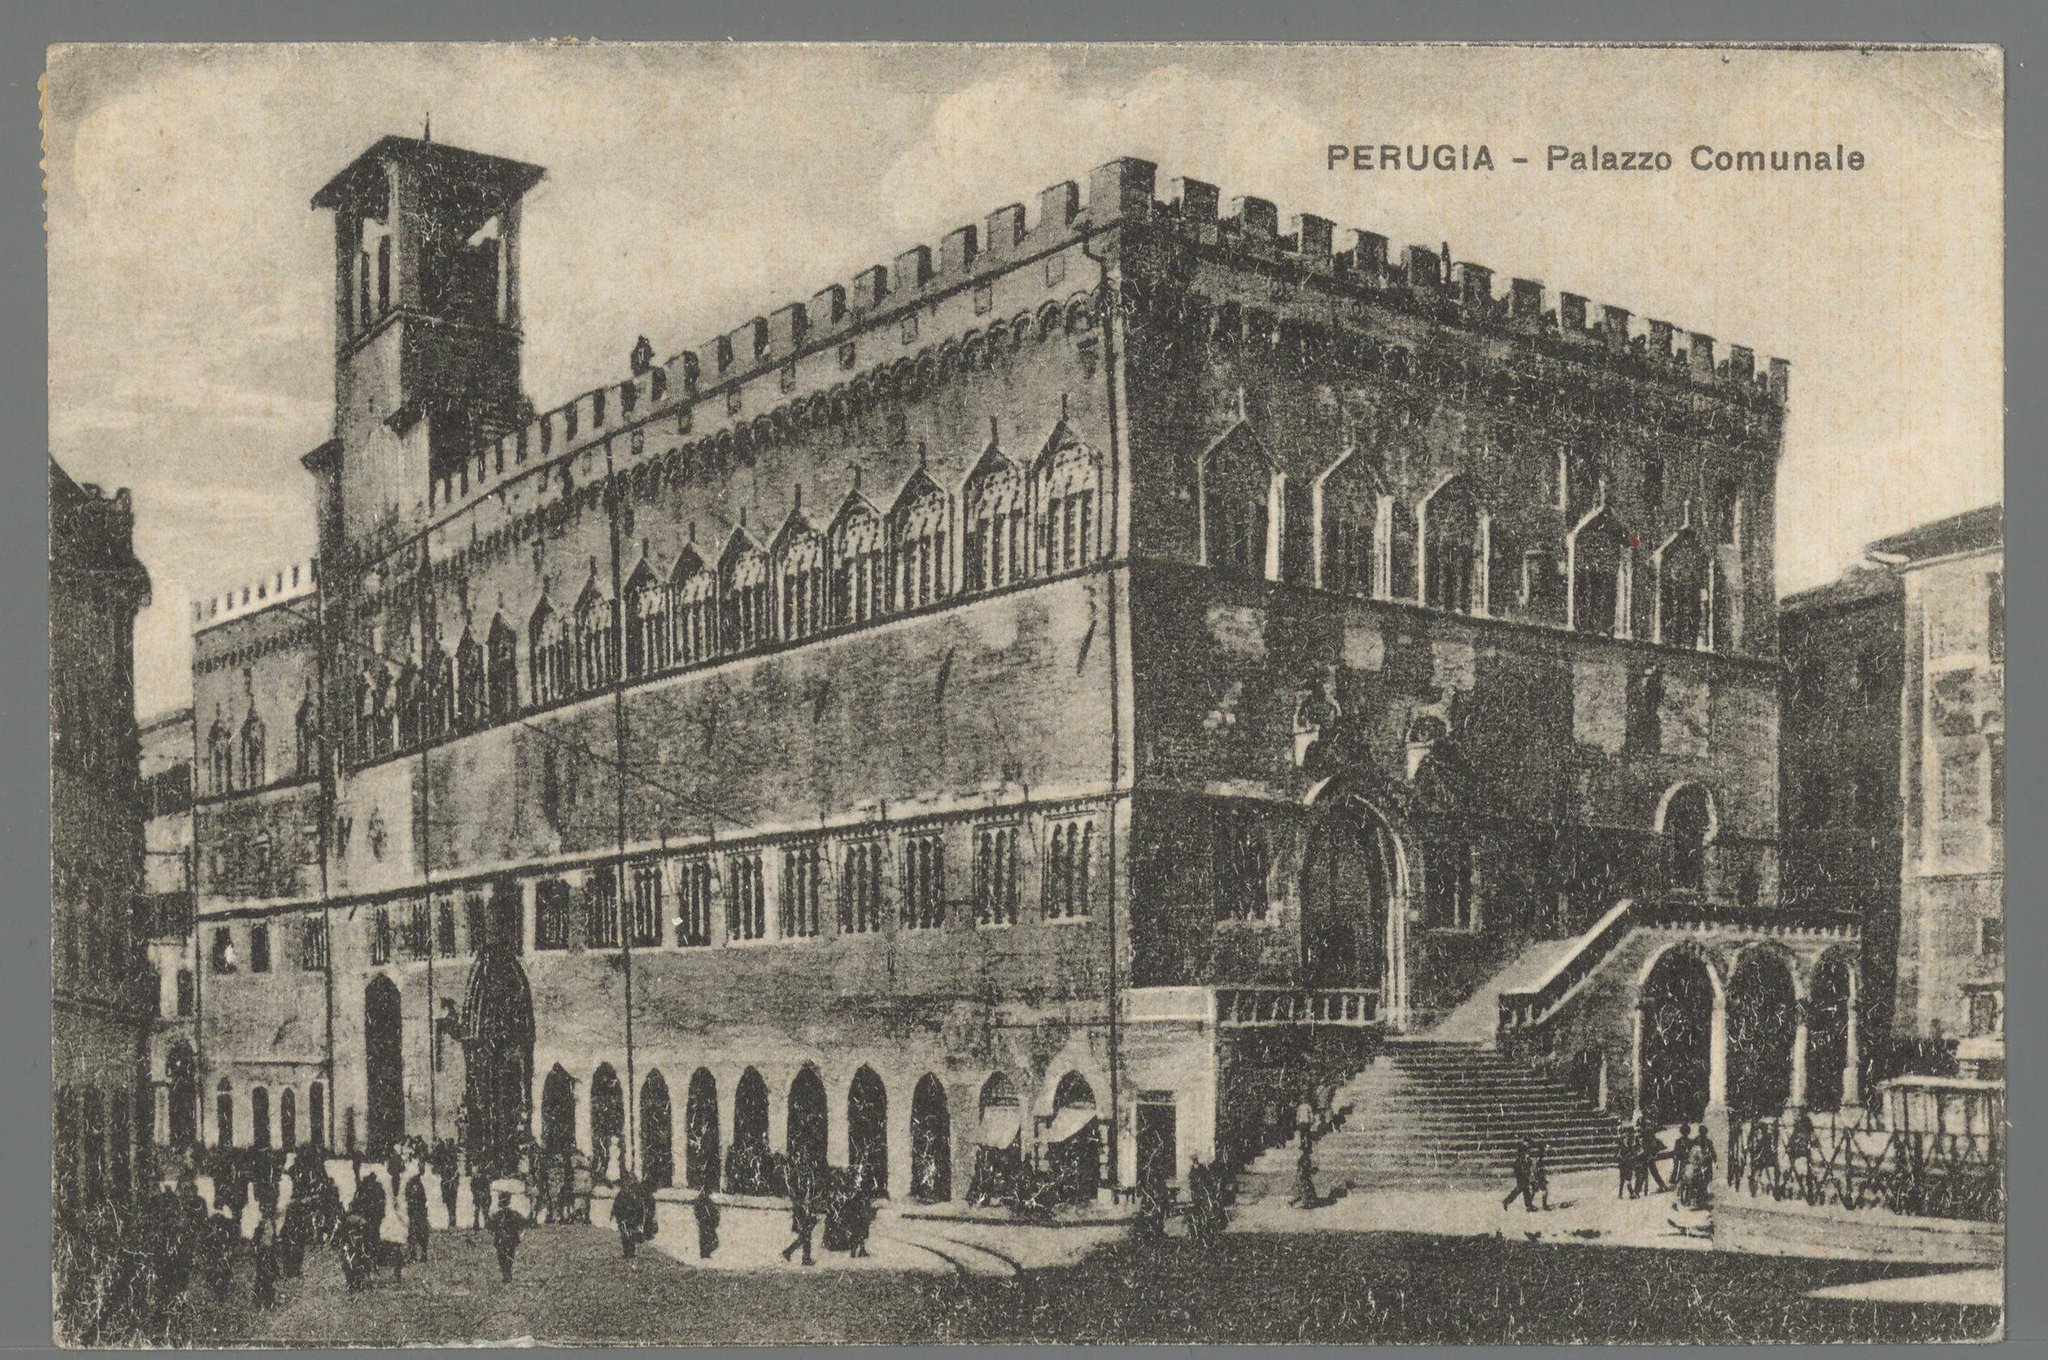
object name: ansichtkaart, prentbriefkaart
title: Perugia. Palazzo Comunale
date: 1906-1912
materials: cardboard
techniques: photograph, writing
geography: perugia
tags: palace, city-view, and landscape with man-made constructions (+ city(-scape) with figures, staffage)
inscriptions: postage stamp